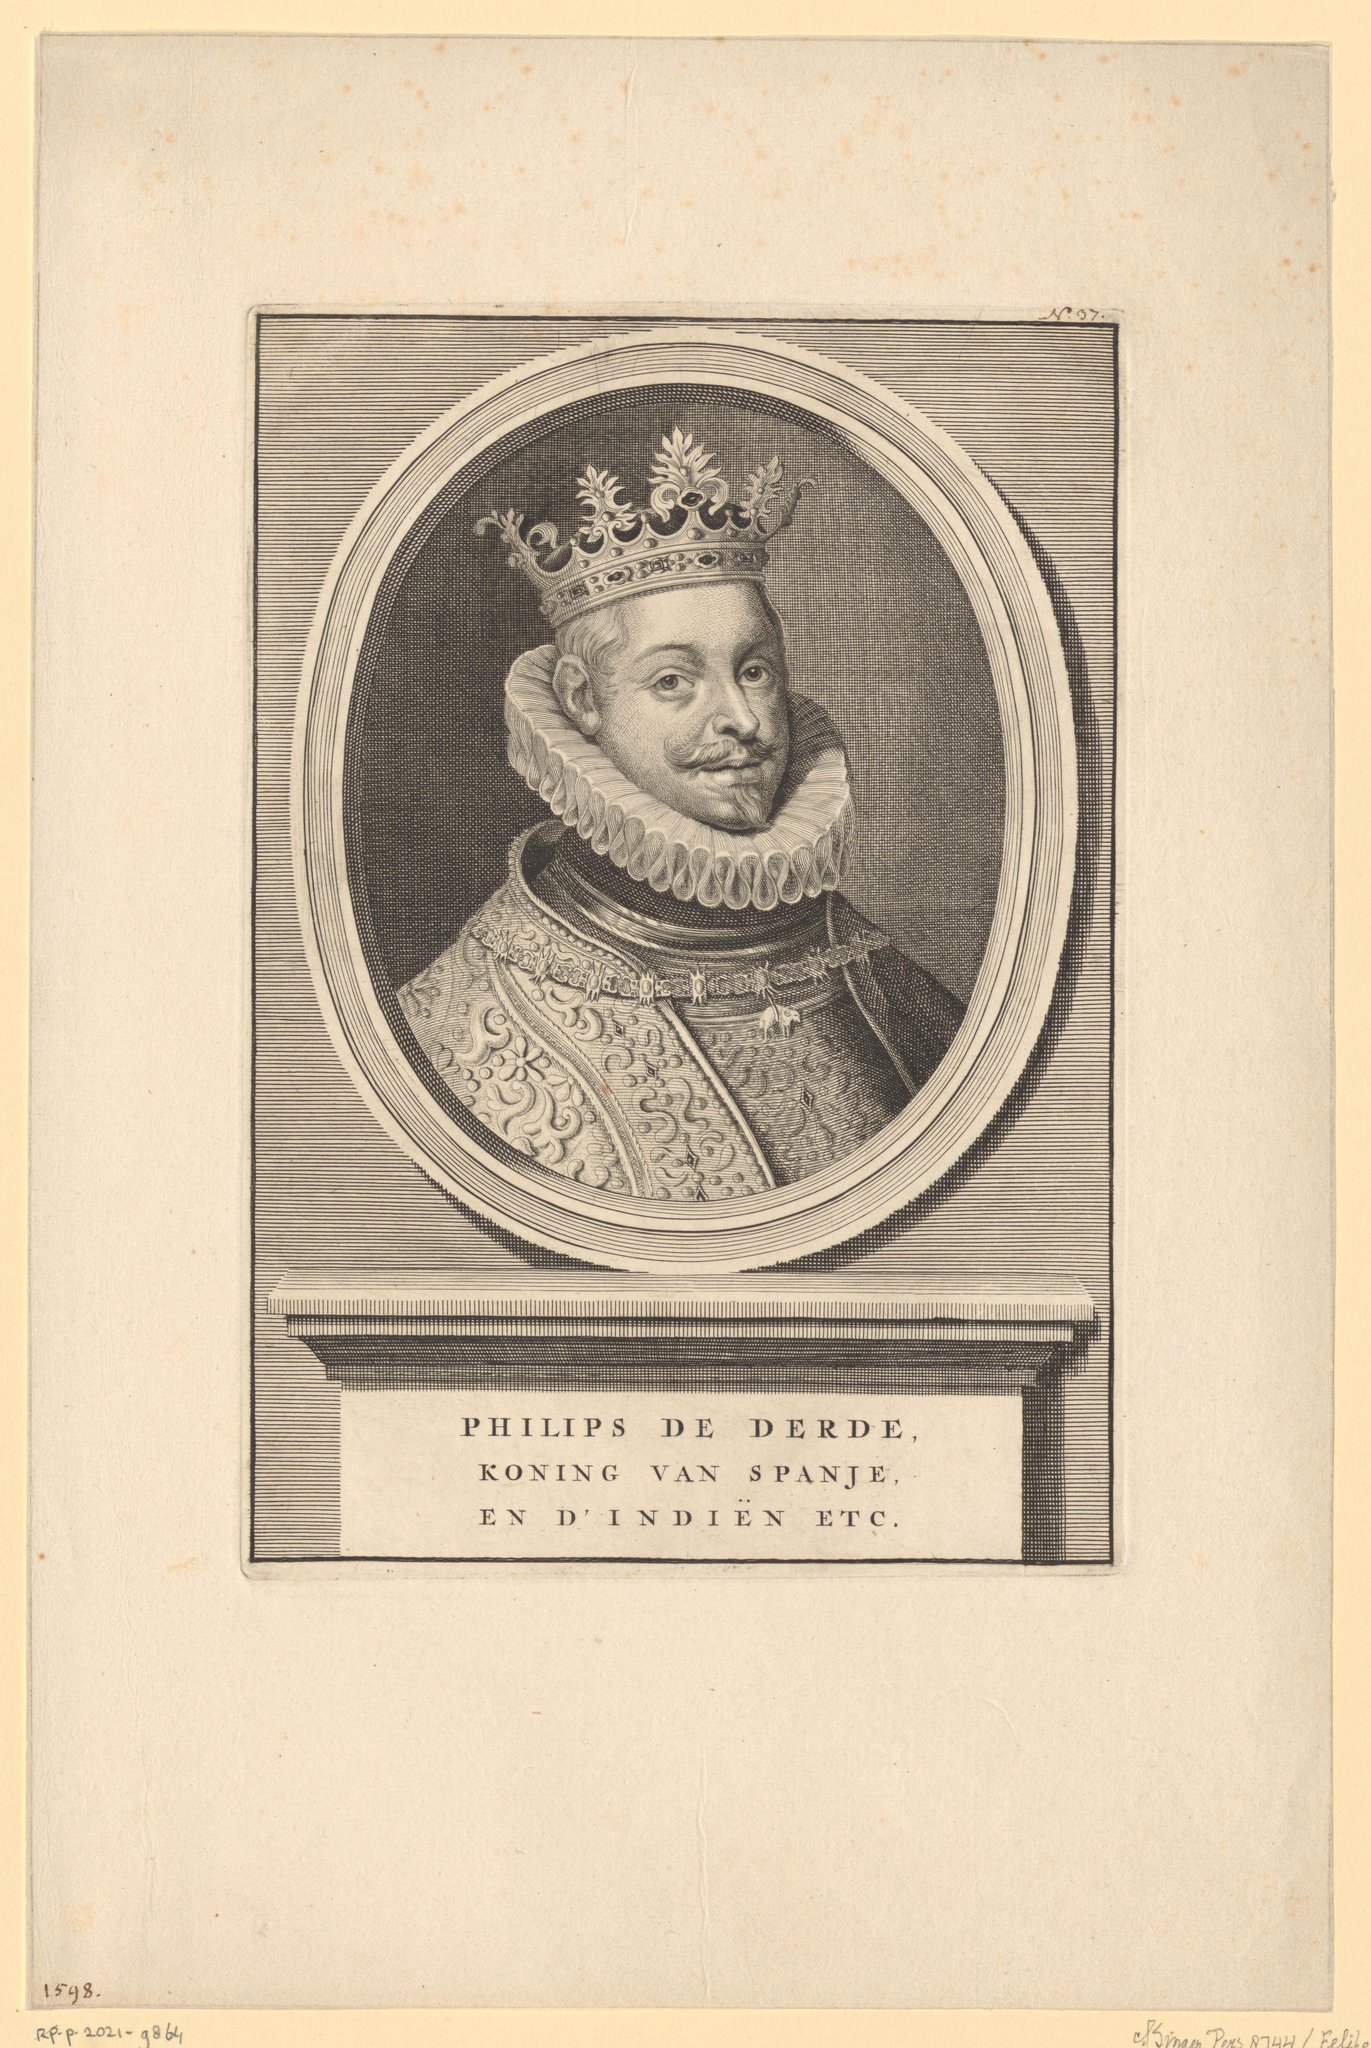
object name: print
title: Portret van Filips III, koning van Spanje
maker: andries vaillant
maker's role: print maker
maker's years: 1655-1693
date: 1679-1684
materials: paper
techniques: engraving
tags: filips iii (koning van spanje), crown (symbol of sovereignty), adult man, historical persons, knighthood order of the golden fleece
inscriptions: inscription: ‘N. 37/ 1598’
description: Prent waarschijnlijk uit: Bor, Pieter Christiaensz. Oorsprongk, begin, en vervolgh der Nederlandsche oorlogen, beroerten, en borgerlyke oneenigheden (...). Amsterdam: weduwe Joannes van Someren, Abraham Wolfgangh en Hendrick en Dirck Boom, 1679-1684.